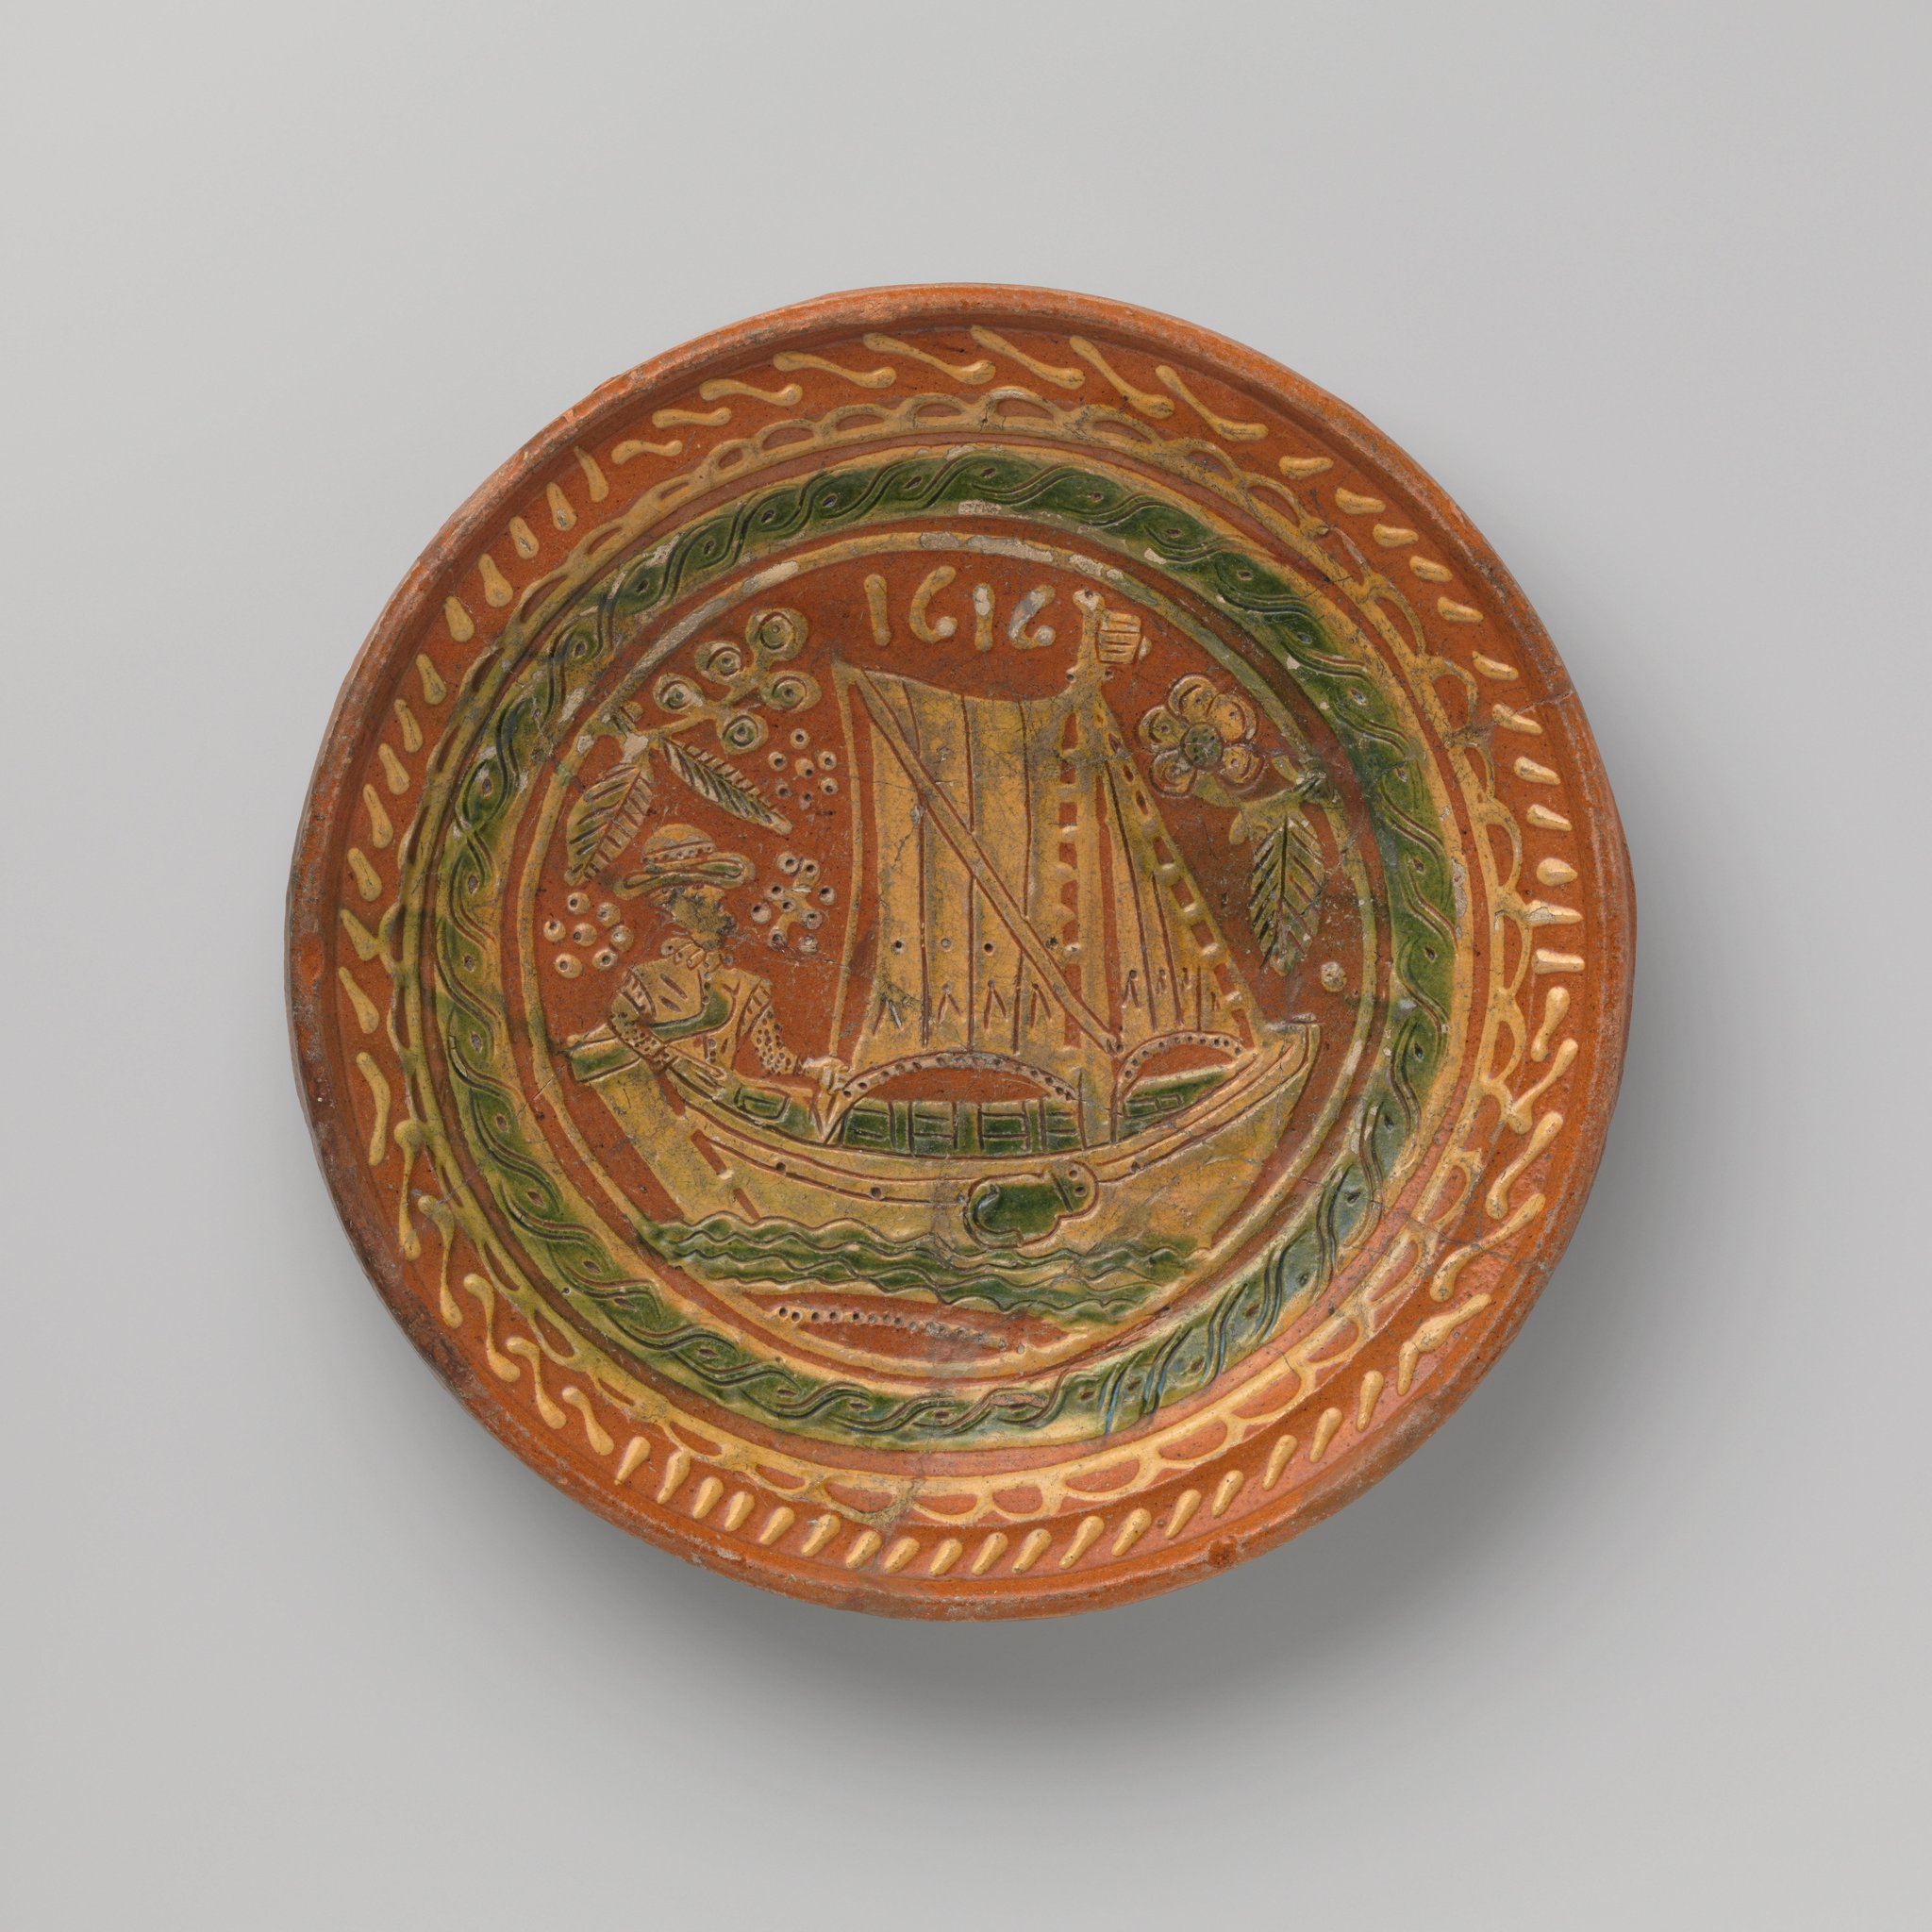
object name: platter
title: Schotel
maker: Anonymous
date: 1616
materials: earthenware, glaze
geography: north holland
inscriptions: date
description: Ronde schotel van loodglazuuraardewerk, op drie schelpvormige poten. De schotel is in witte slib gedecoreerd, met op het plat een zeilschip. Aan het roer zit een man en boven de boot staat het jaartal 1616. Eromheen is een brede krans geschilderd. De schotel is bedekt met plaatselijk groen getinte loodglazuur.